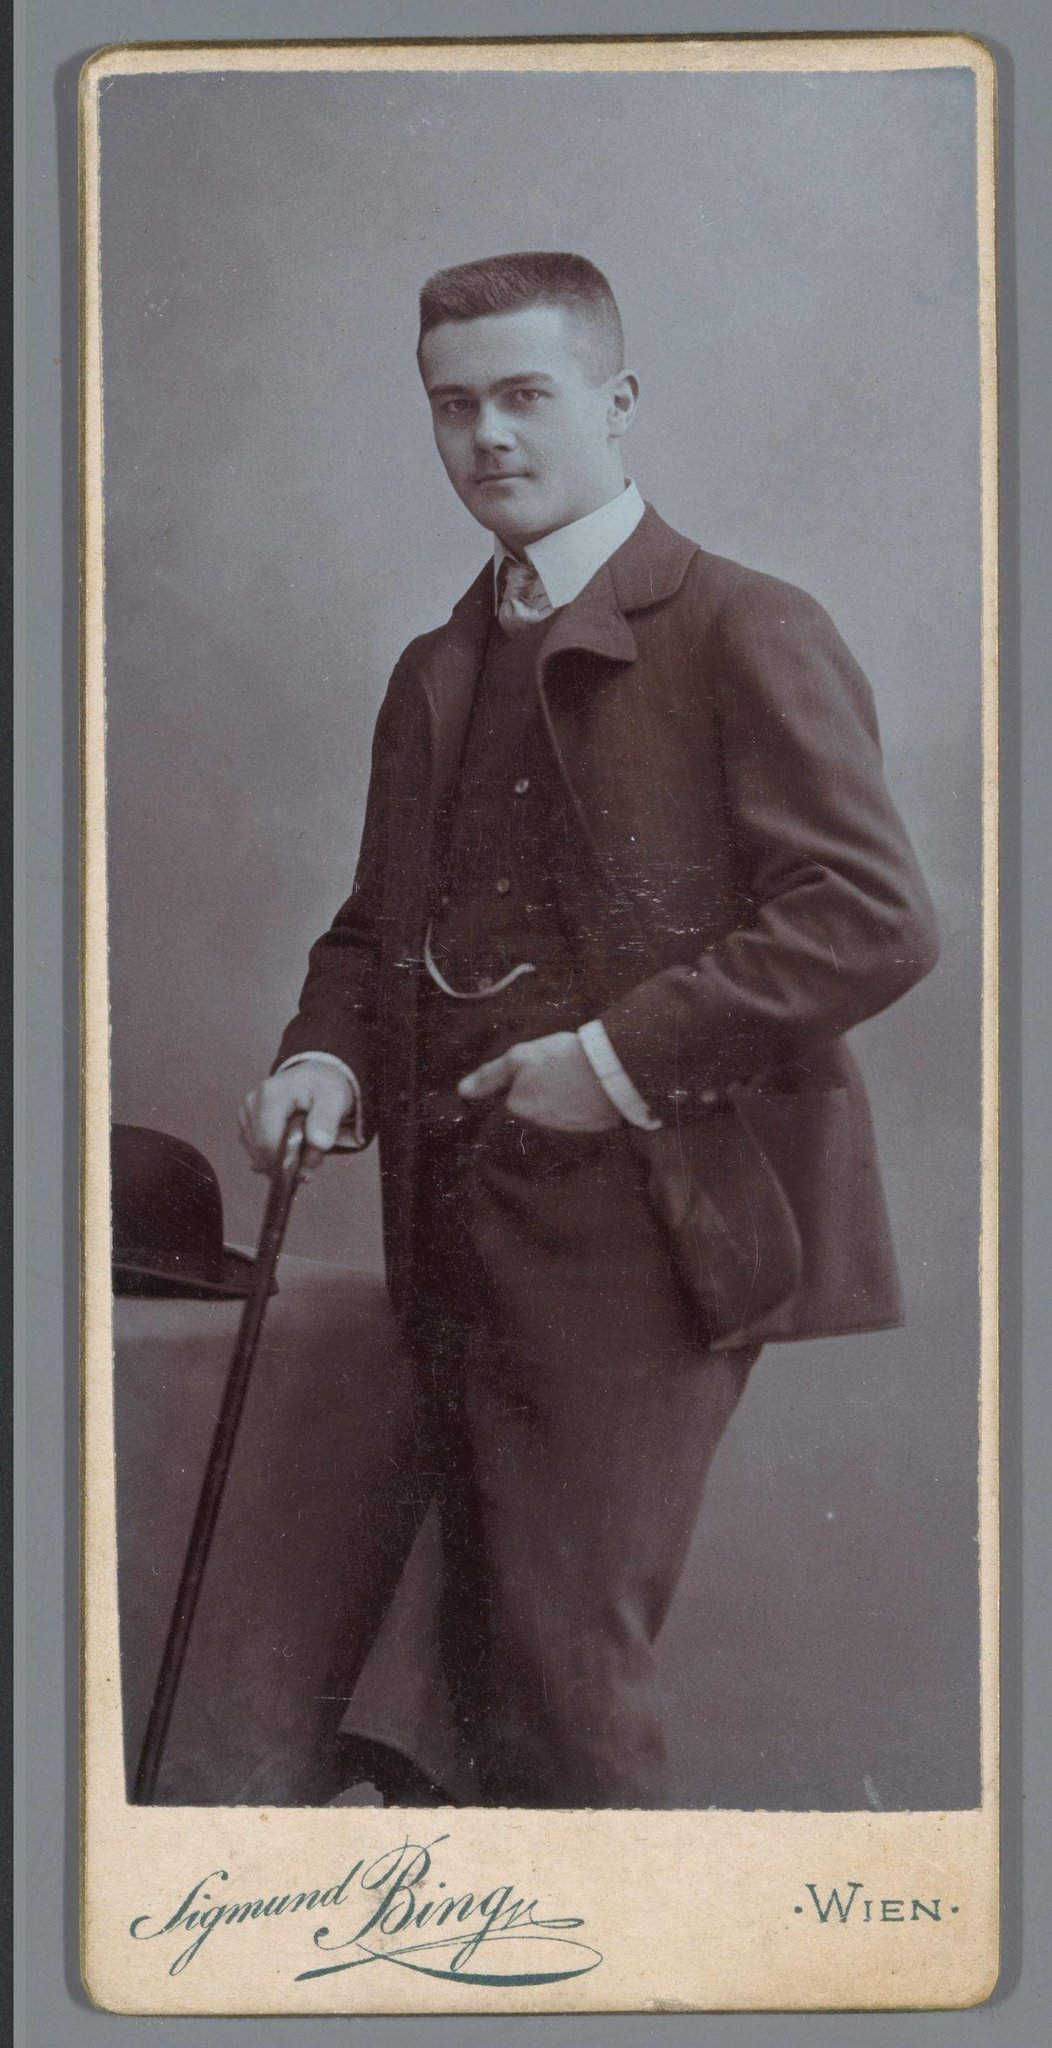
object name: photograph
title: Portret van een man, aangeduid als Anton Zettner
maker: sigmund bing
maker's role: fotograaf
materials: paper, cardboard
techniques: collodion silver print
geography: vienna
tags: adult man, anonymous historical person portrayed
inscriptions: inscription: ‘Zur freundlichen/ Errinnerung an Anton Zettner’, number: ‘47407’, address: ‘Wien,/ I, Goldschmidgasse 4/ (Ecke Stefansplatz.)/ II. Bez./ Photographie Palast/ an der Marienbrücke./ III. Bez./ Landstrasse, Hauptstrasse 27/ XVII. Bez./ Hernalser Hauptstrasse 17/ (im Garten.)’